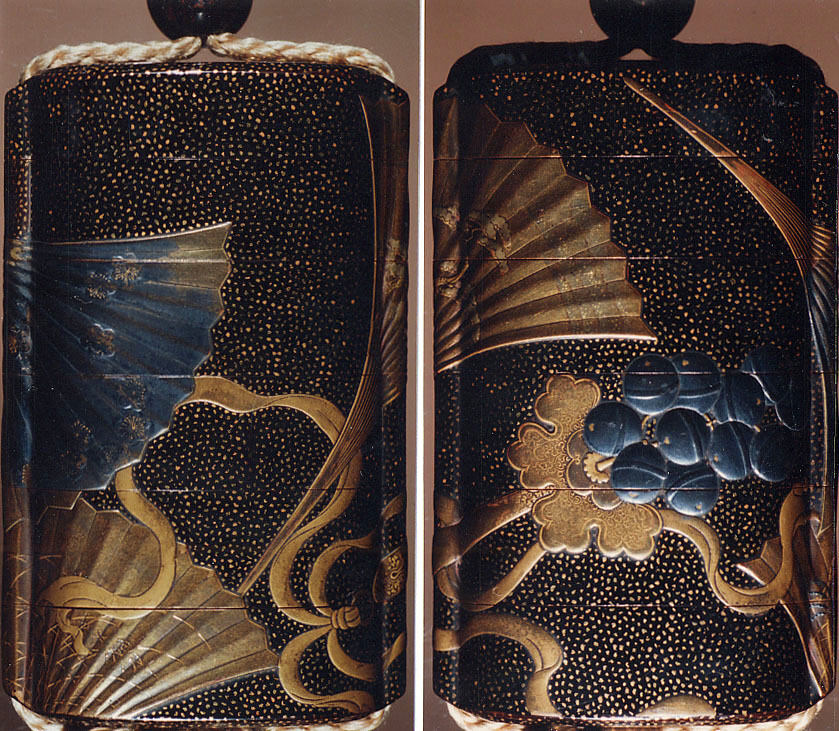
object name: inrō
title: Case (Inrō) with Design of Dancer's Bells and Fans with Plum Blossoms, Pines and Grass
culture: japanese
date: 1701-1900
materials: foil, gold, lacquer, silver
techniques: fundame, hiramakie, roiro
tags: fans,bells